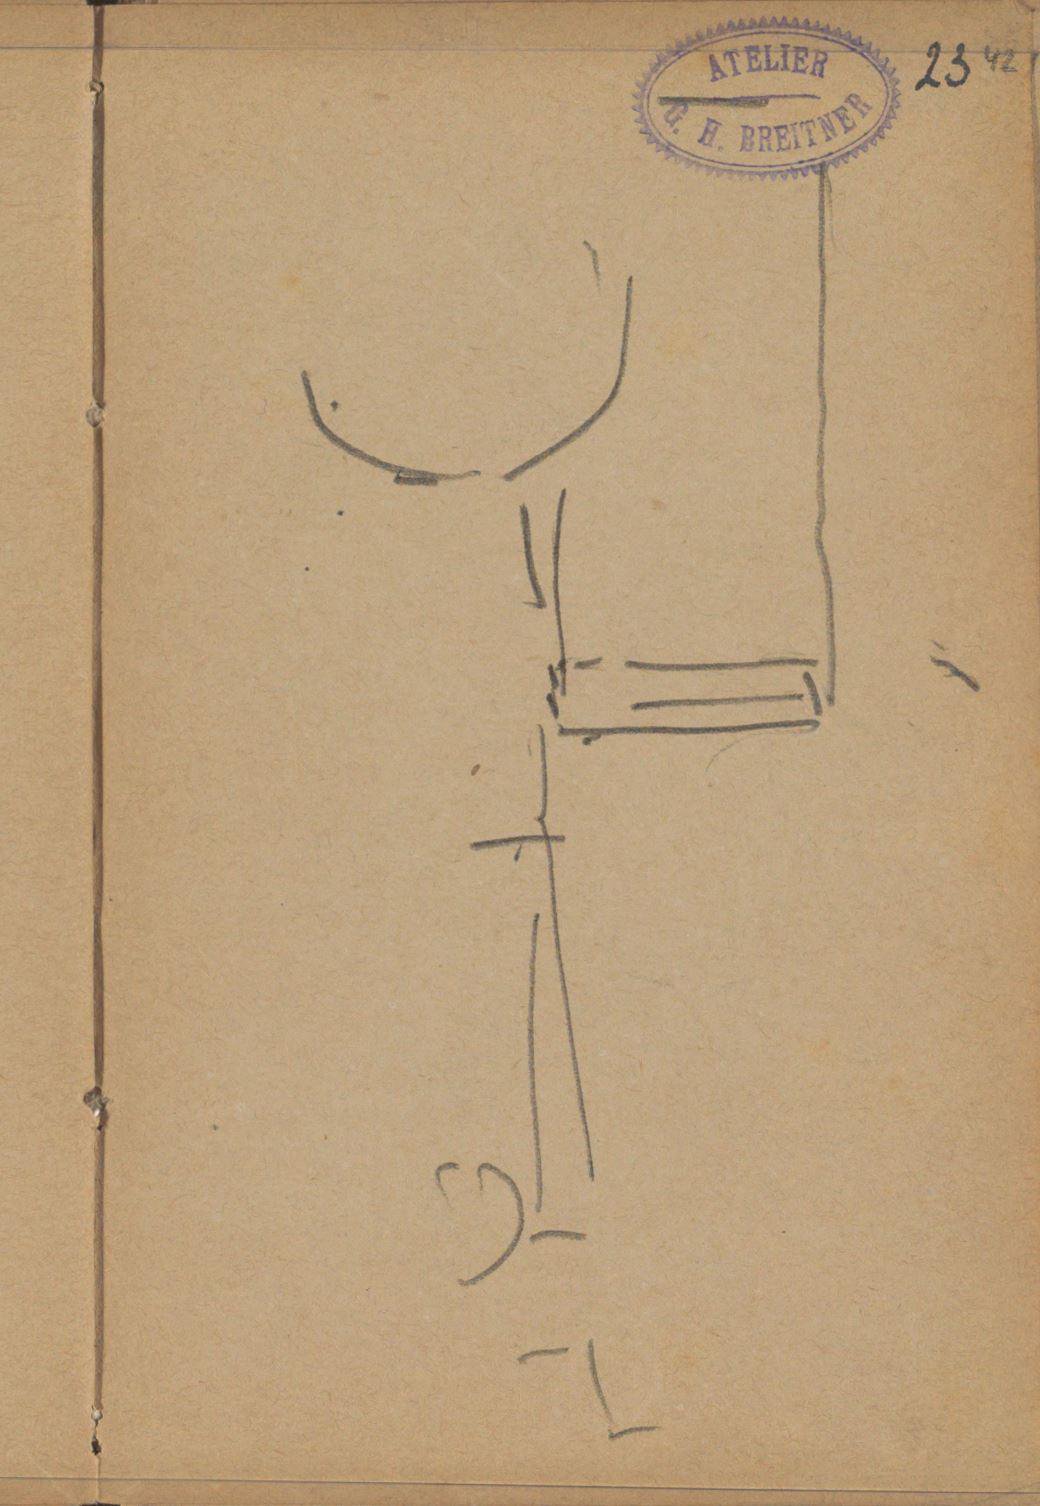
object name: sketchbook leaf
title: Kar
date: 1887-1891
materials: paper, pencil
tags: (farm) wagon, freight wagon, cart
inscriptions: workshop stamp: Lugt 291d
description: Pagina 42 uit een schetsboek met 83 bladen.